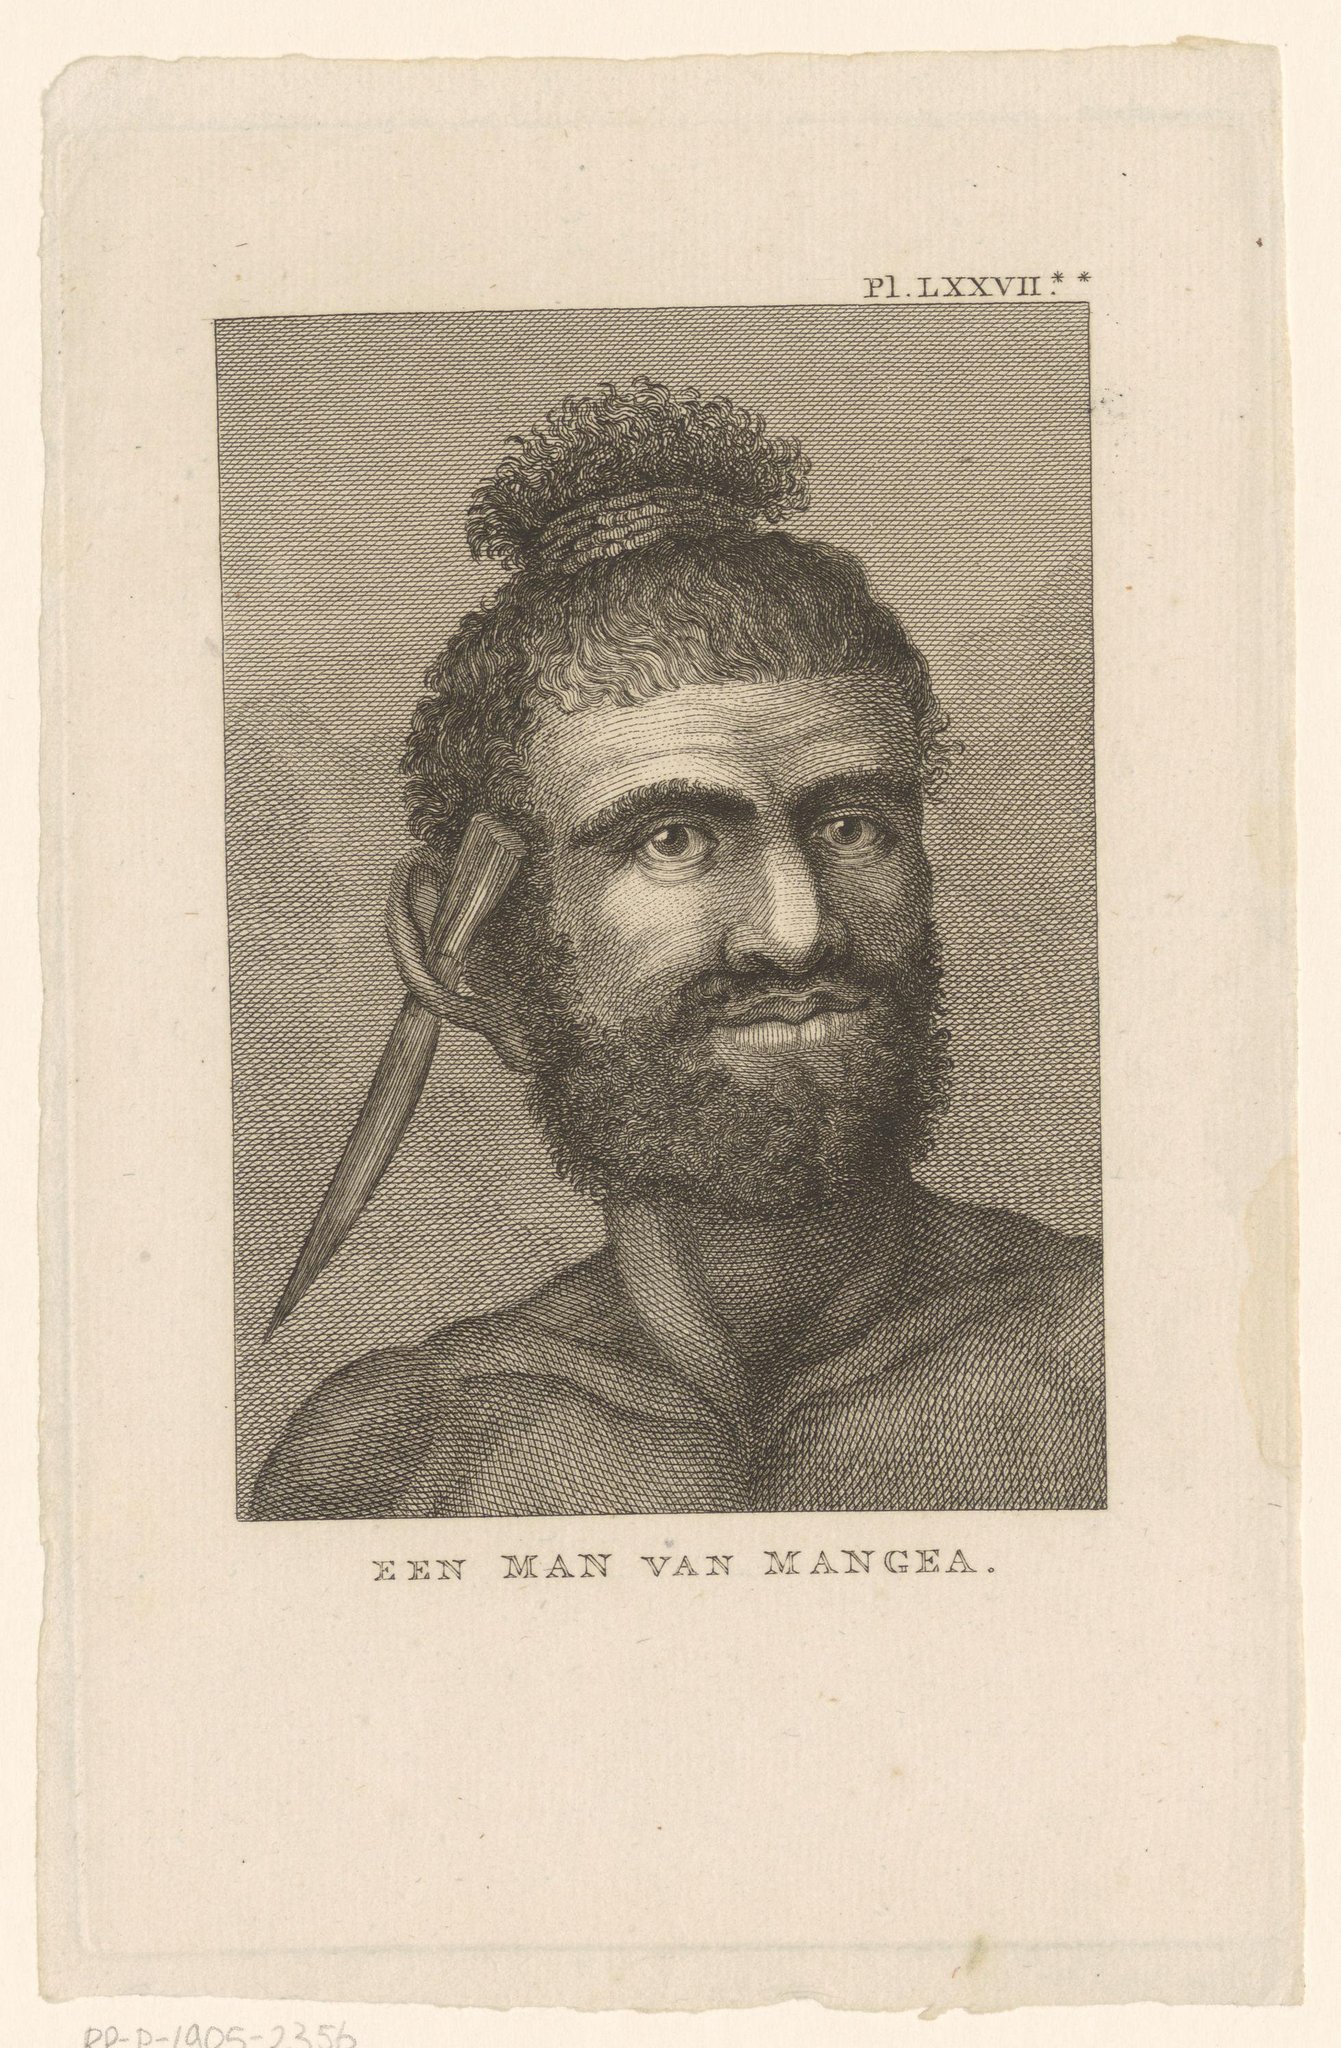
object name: book illustration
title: Portret van een onbekende man afkomstig van het eiland Mangea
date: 1795-1803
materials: paper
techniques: engraving, etching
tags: adult man, anonymous historical person portrayed, folk costume, regional costume, ear-rings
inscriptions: number: ‘LXXXVII’, collector's mark: Lugt 2228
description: De prent is gebruikt in: Cook, James. Reize rondom de Waereld (...) met kaarten en plaaten. [Vertaald uit het Engels door] Jan David Pasteur. Leiden: Honkoop, Amsterdam: Allart, Den Haag: Van Cleef, 1795-1803, dl. 13.